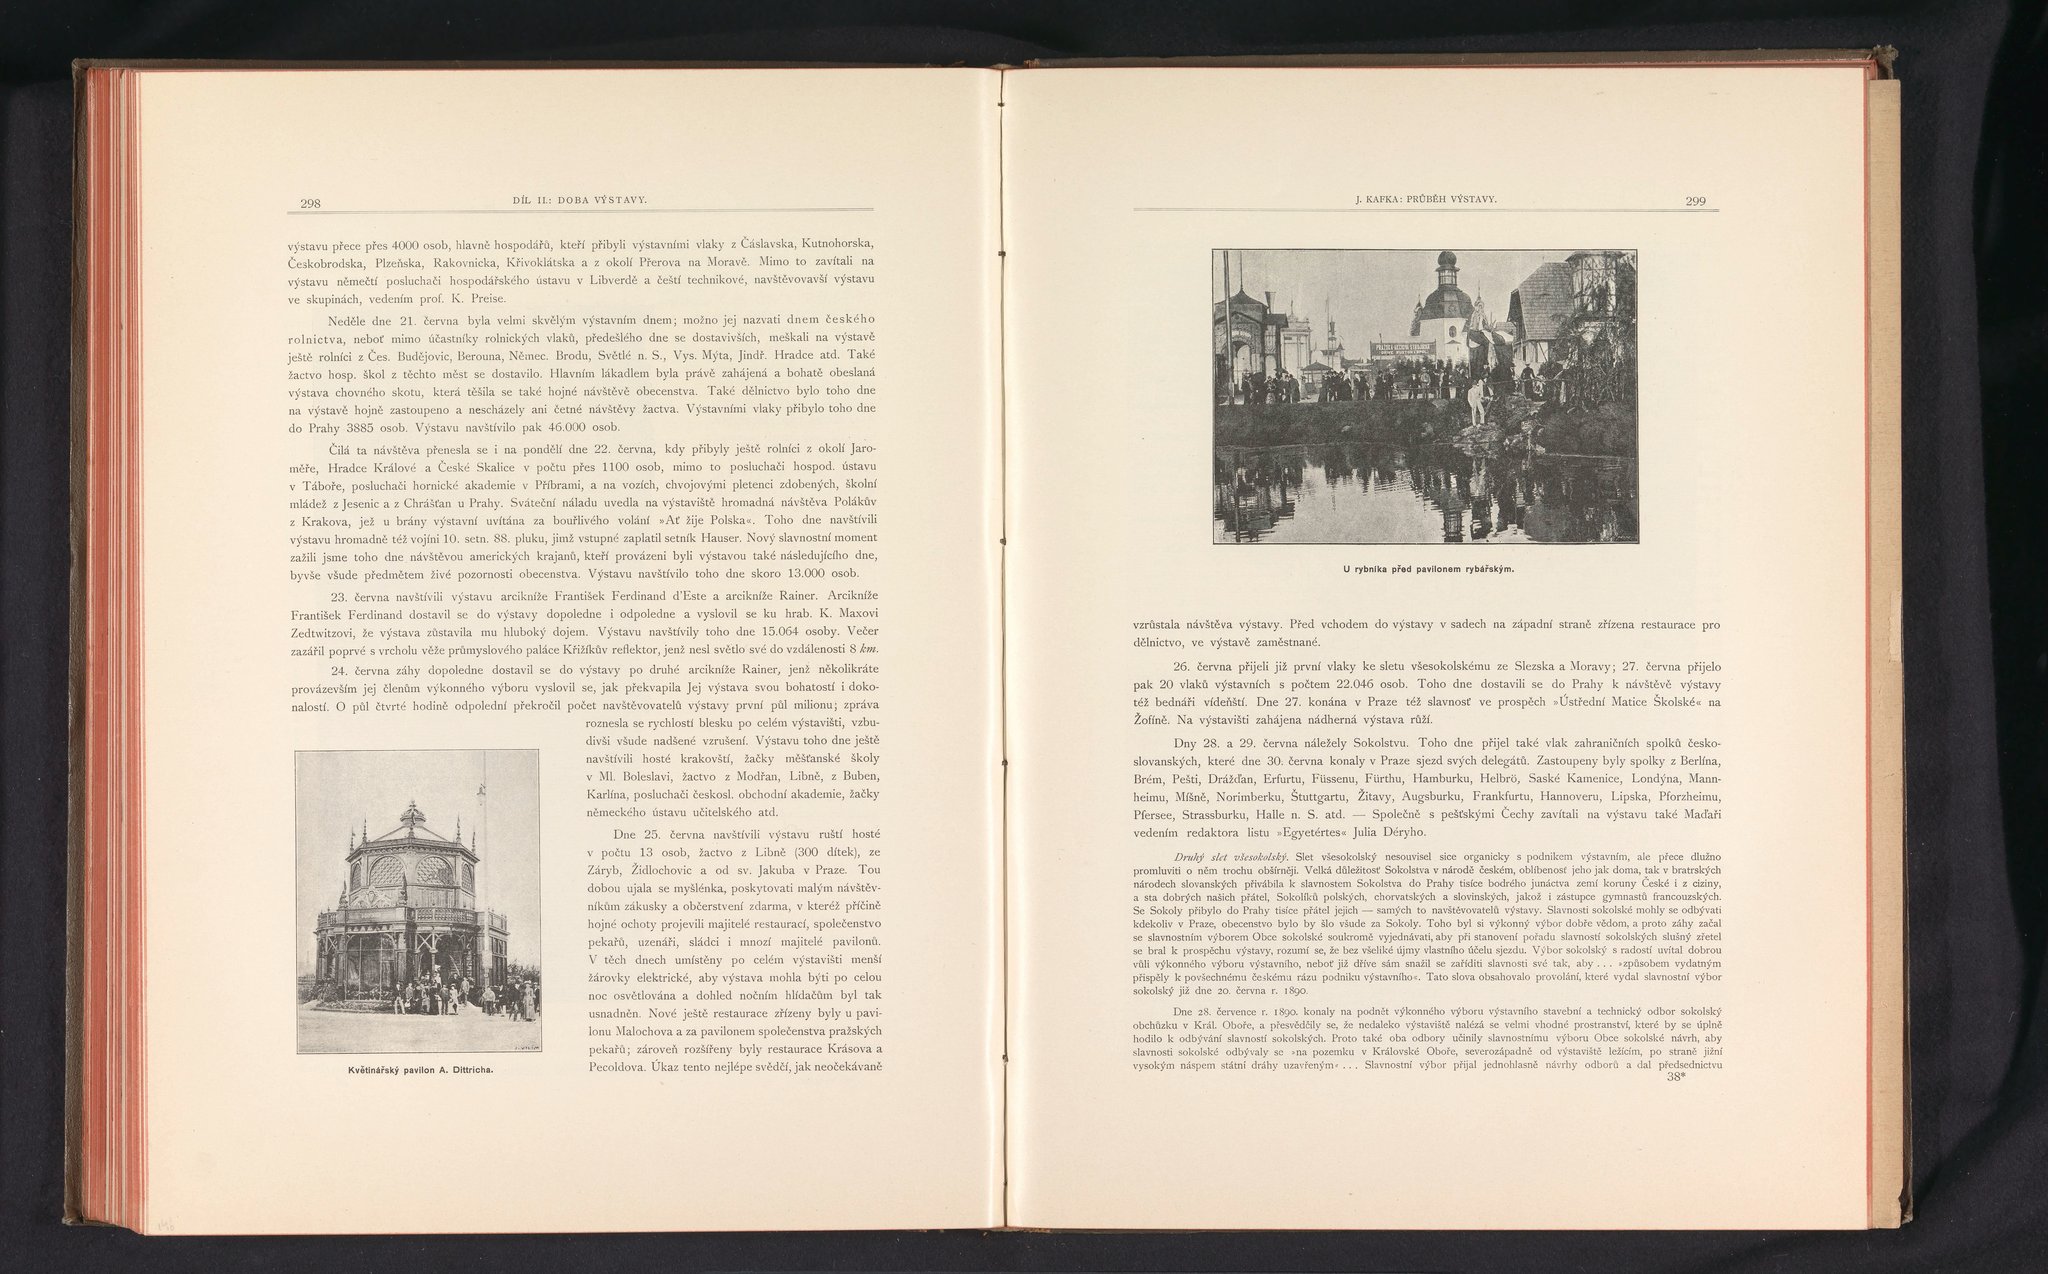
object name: page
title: U rybnika pred pavilonem rybarským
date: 1891-1893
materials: paper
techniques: autotype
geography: prague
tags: fish pond (in garden), façade (of house or building)